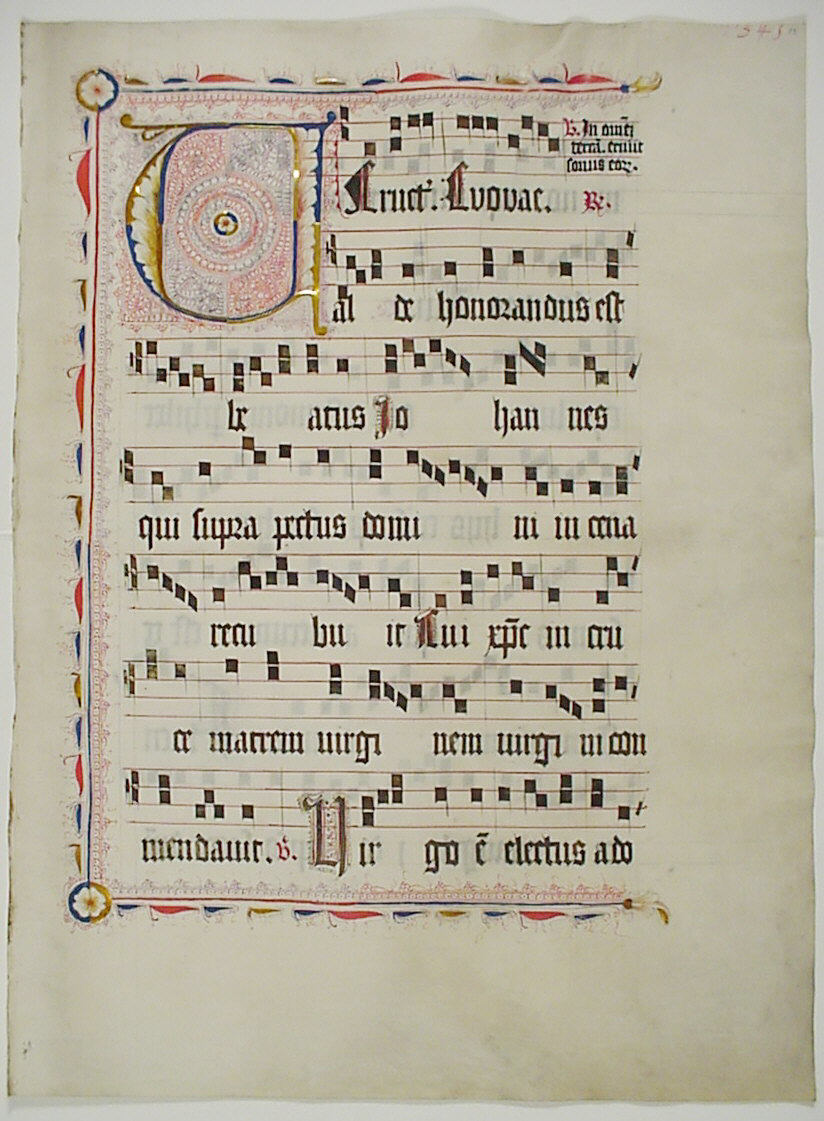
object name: antiphonary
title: Manuscript Leaf with Initial V, from an Antiphonary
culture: german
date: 1426-1450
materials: ink, metal leaf, parchment, paint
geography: germany